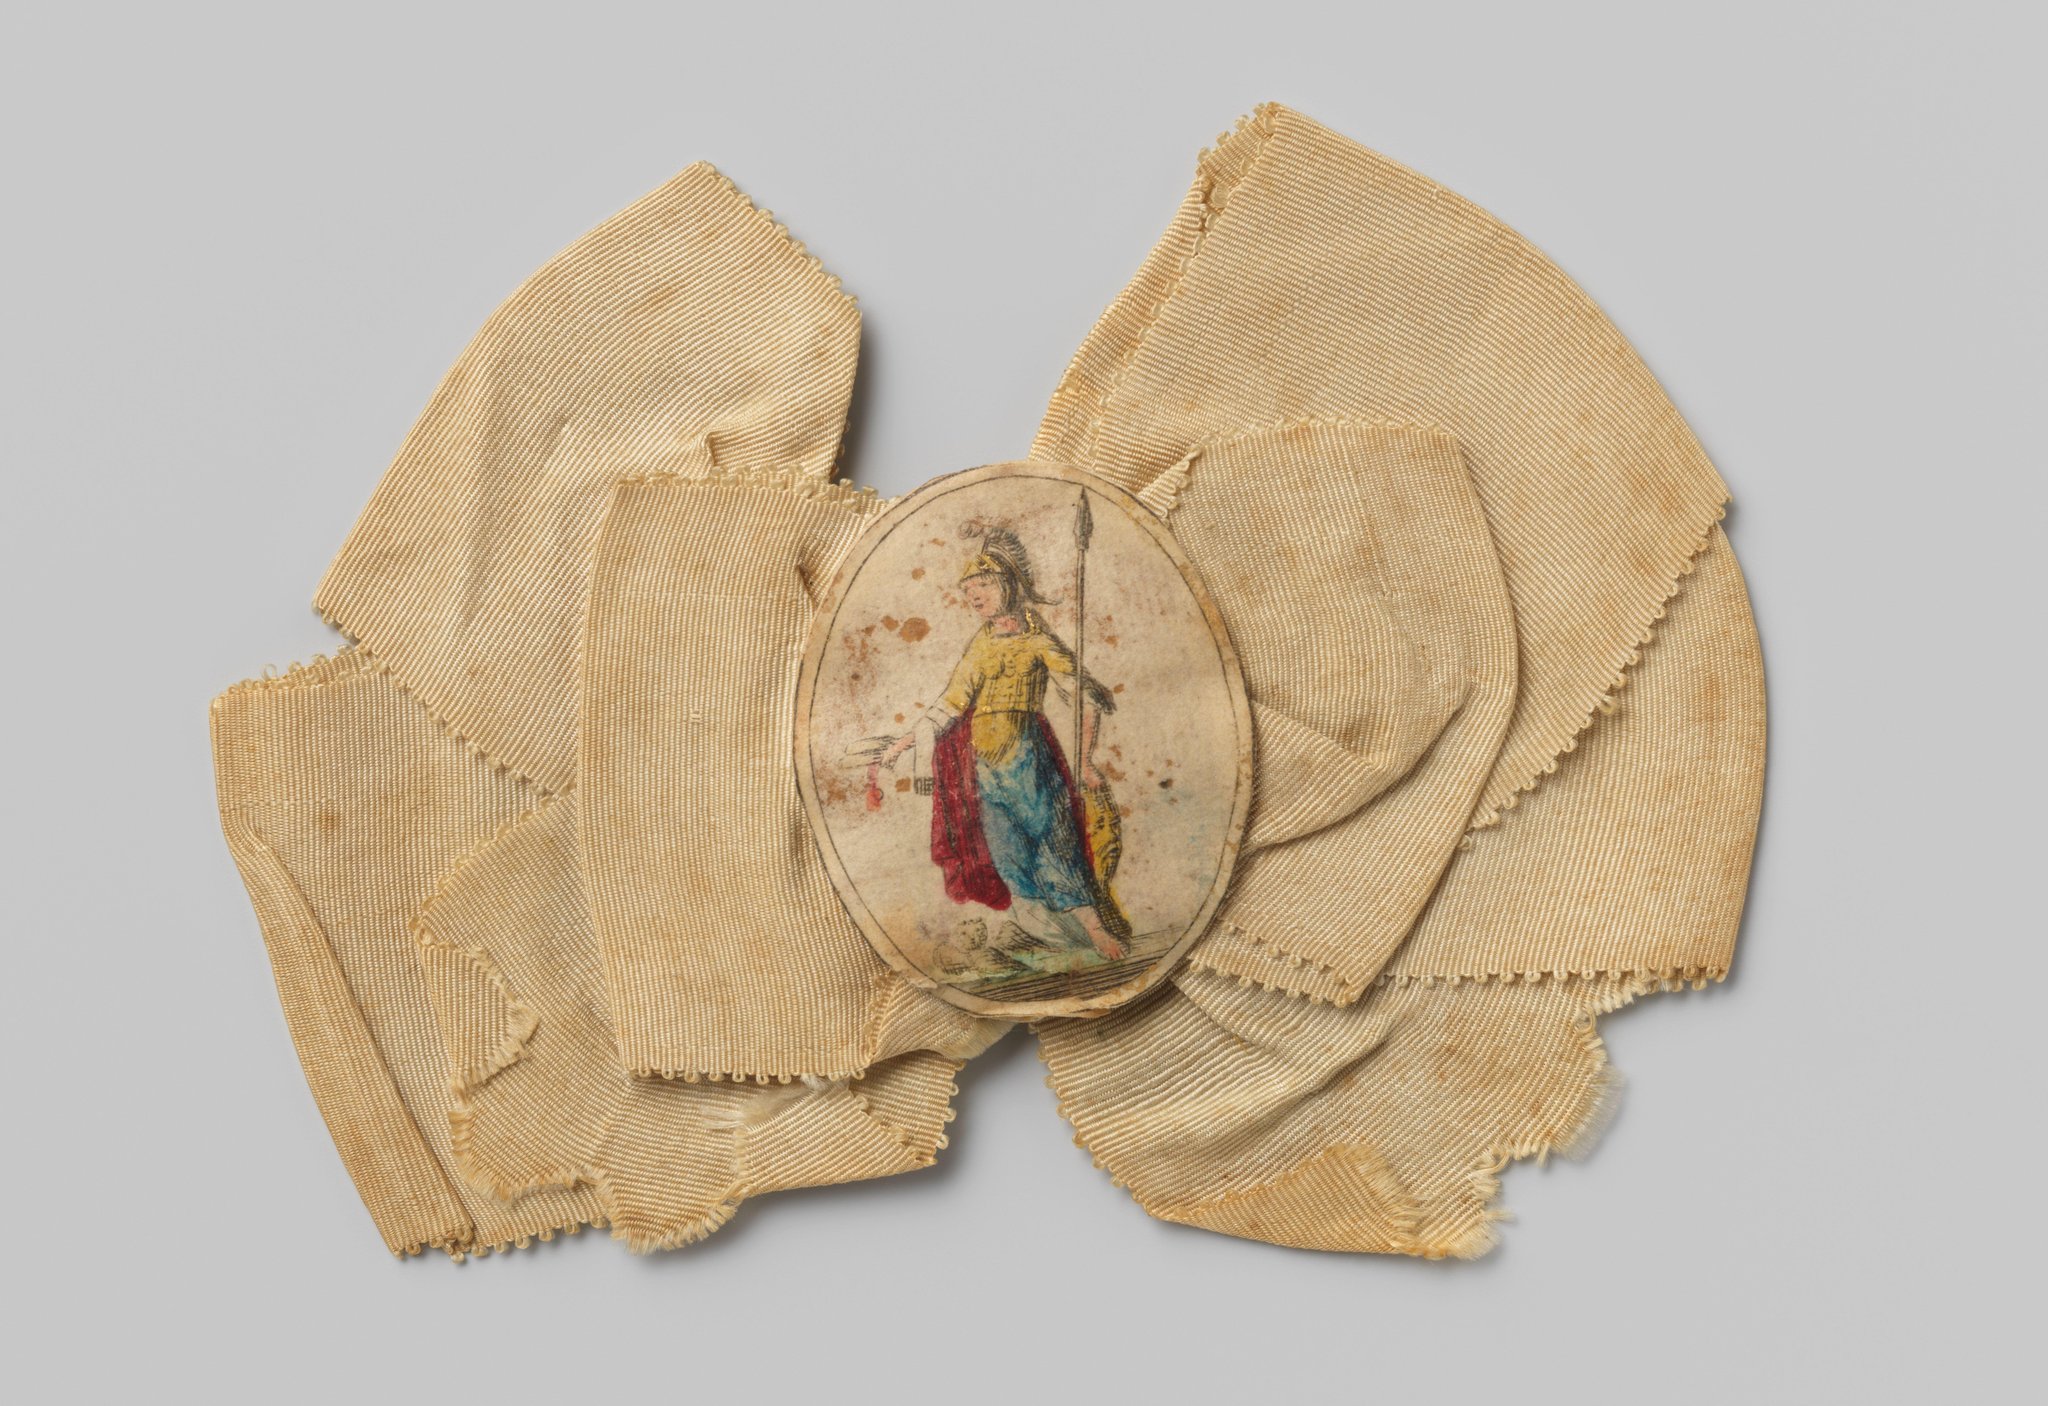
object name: bow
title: Oranjestrik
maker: Anonymous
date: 1750-1800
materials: paper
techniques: colour, engraving, stitching, weave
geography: netherlands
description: Verschoten oranje strik waarop een ovale papieren medaillon is bevestigd. Op het medaillon staande vrouw met helm. In haar rechterhand een verzegelde rol, in haar linkerhand een masker en speer, aan haar voeten een uiltje. Sporen van goudverf als omlijsting.